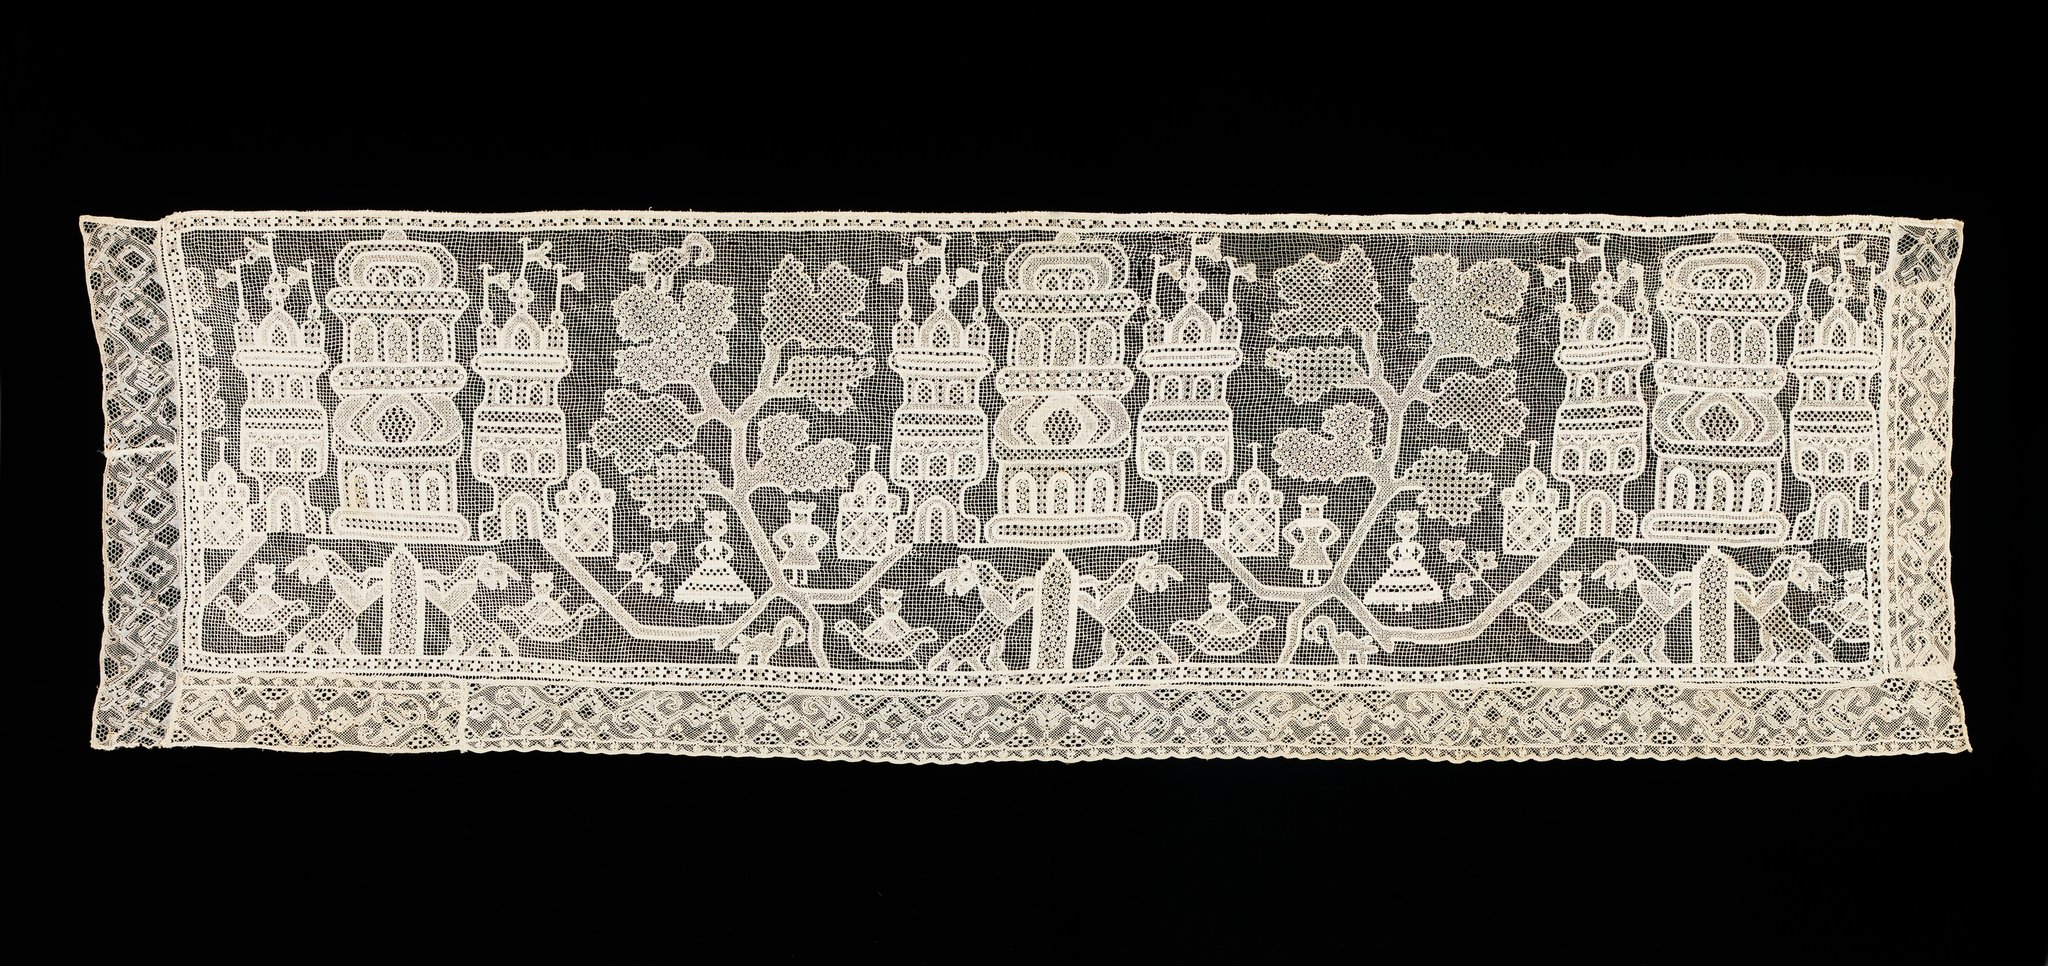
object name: border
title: Bed curtain border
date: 1876-1900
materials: linen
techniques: lace, embroidery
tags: buildings